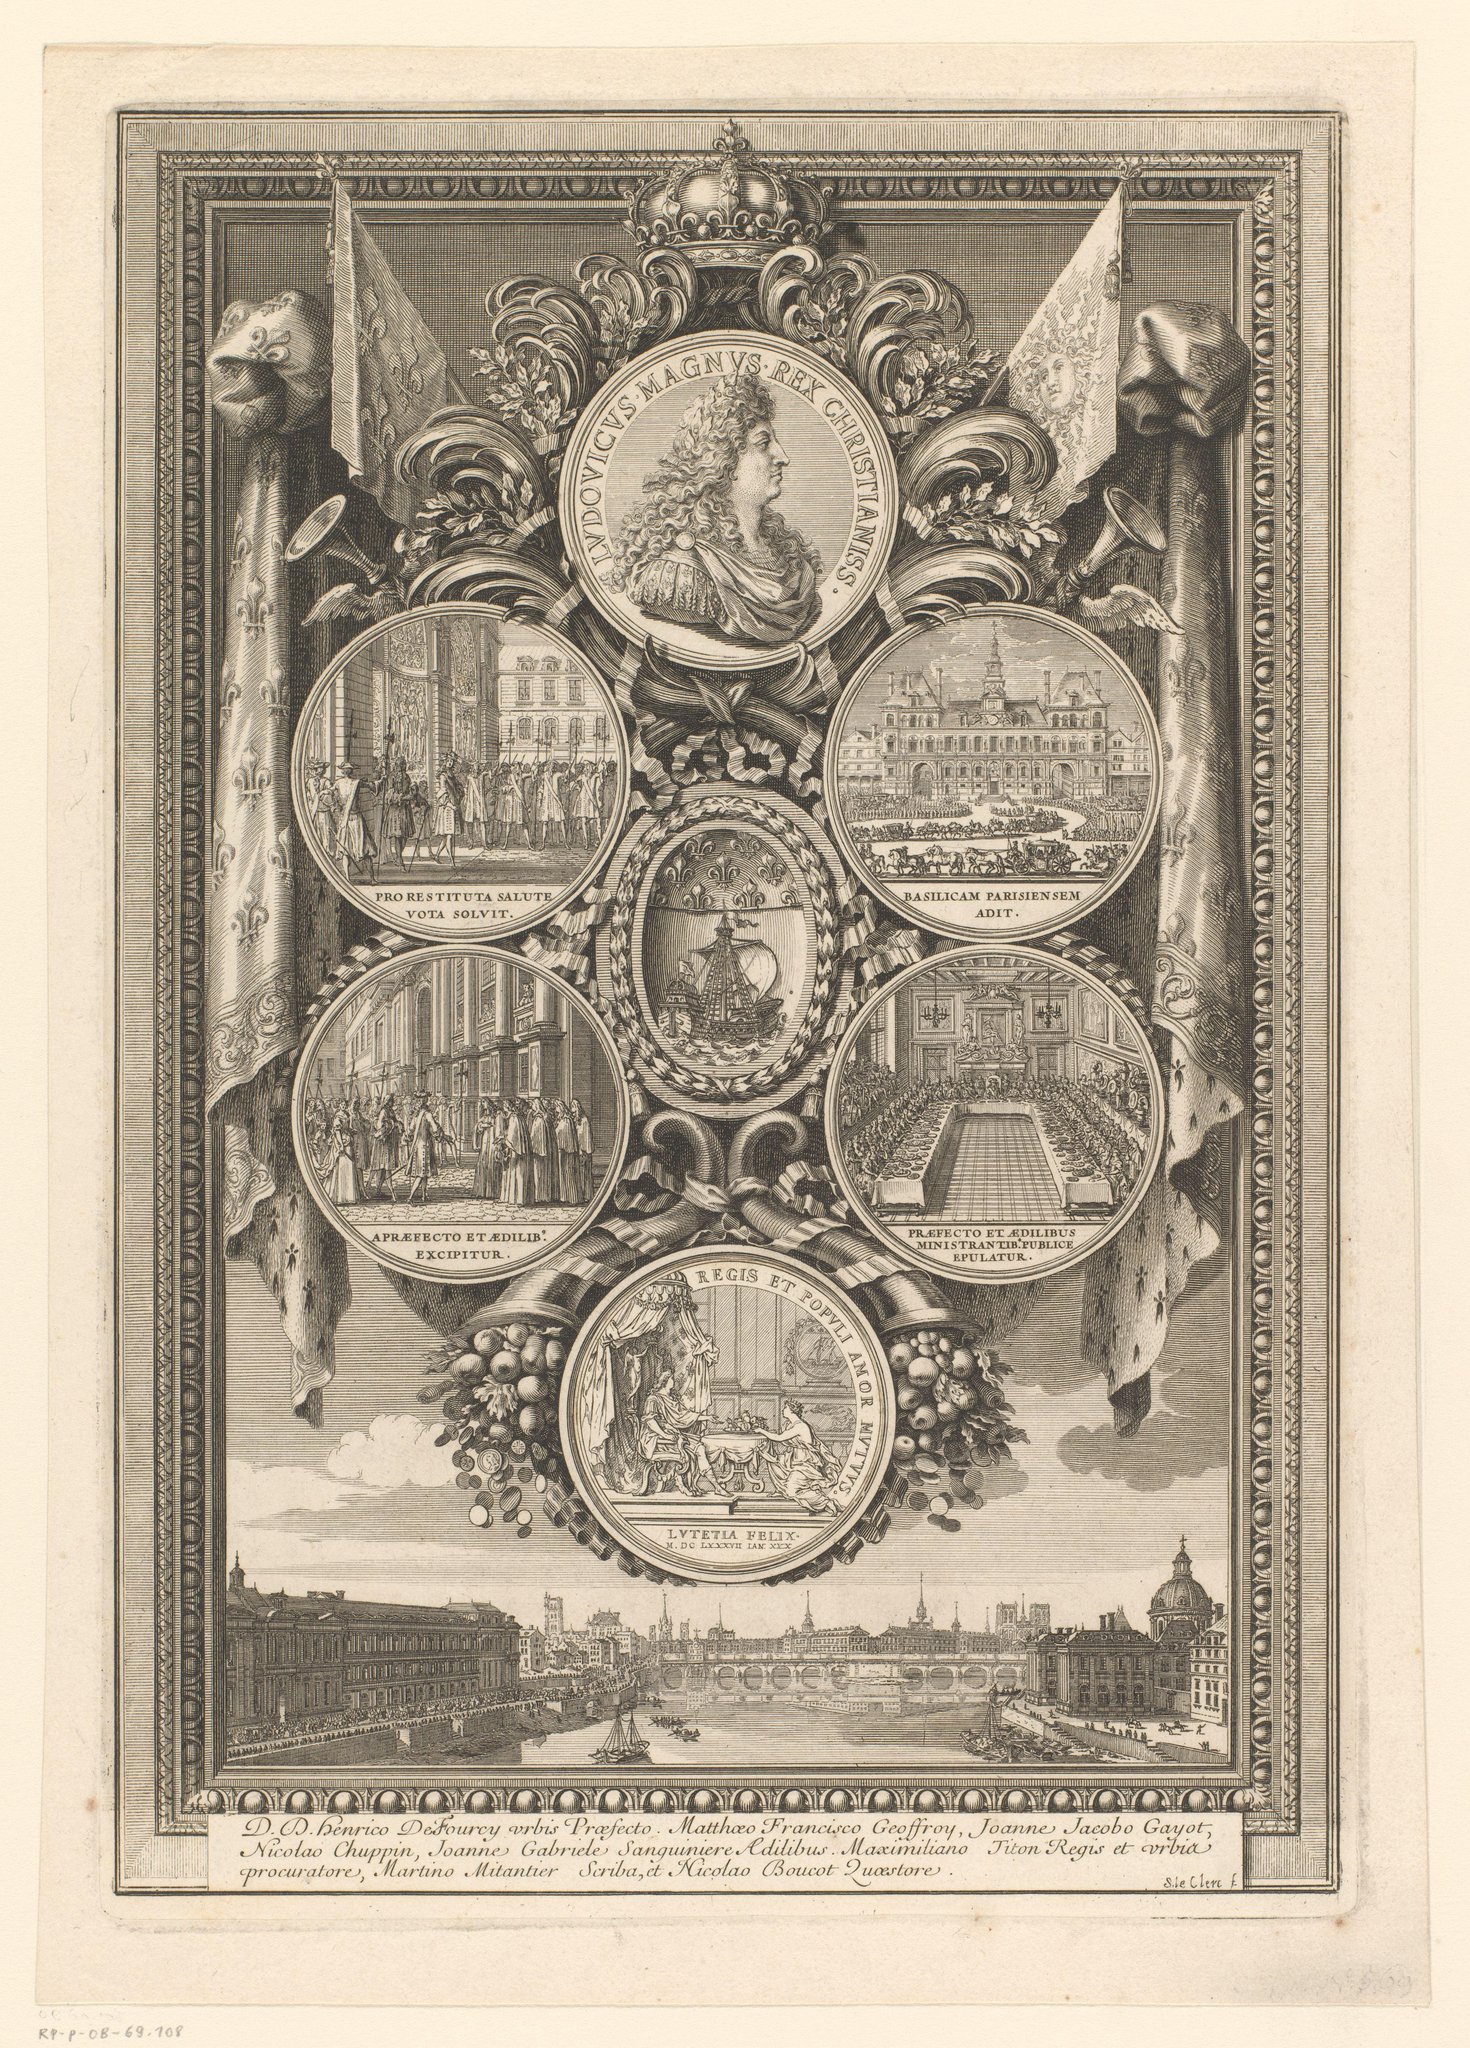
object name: print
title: Ontvangst van Lodewijk XIV op het stadhuis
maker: sébastien leclerc (i)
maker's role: print maker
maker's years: 1637-1714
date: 1687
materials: paper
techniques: engraving, etching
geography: france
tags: lodewijk xiv (koning van frankrijk), historical persons, ruler, sovereign, bridge in city across river, canal, etc., paris